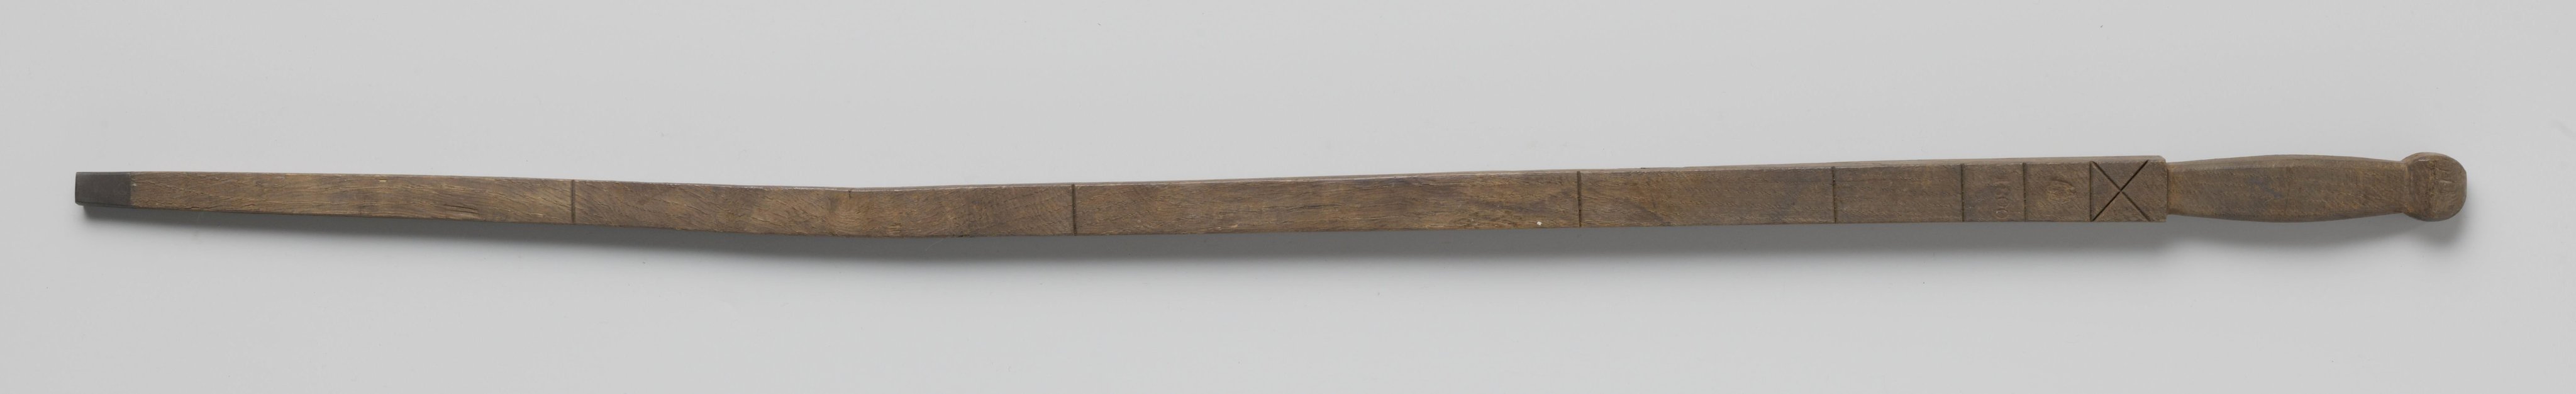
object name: ellemaat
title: Ellemaat met handvat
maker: Anonymous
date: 1800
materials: metal, wood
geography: germany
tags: netherlands, germany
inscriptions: date: ‘1800’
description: Lengtemaat van 1 el met handvat en metalen dook. V.z.v. stempel.